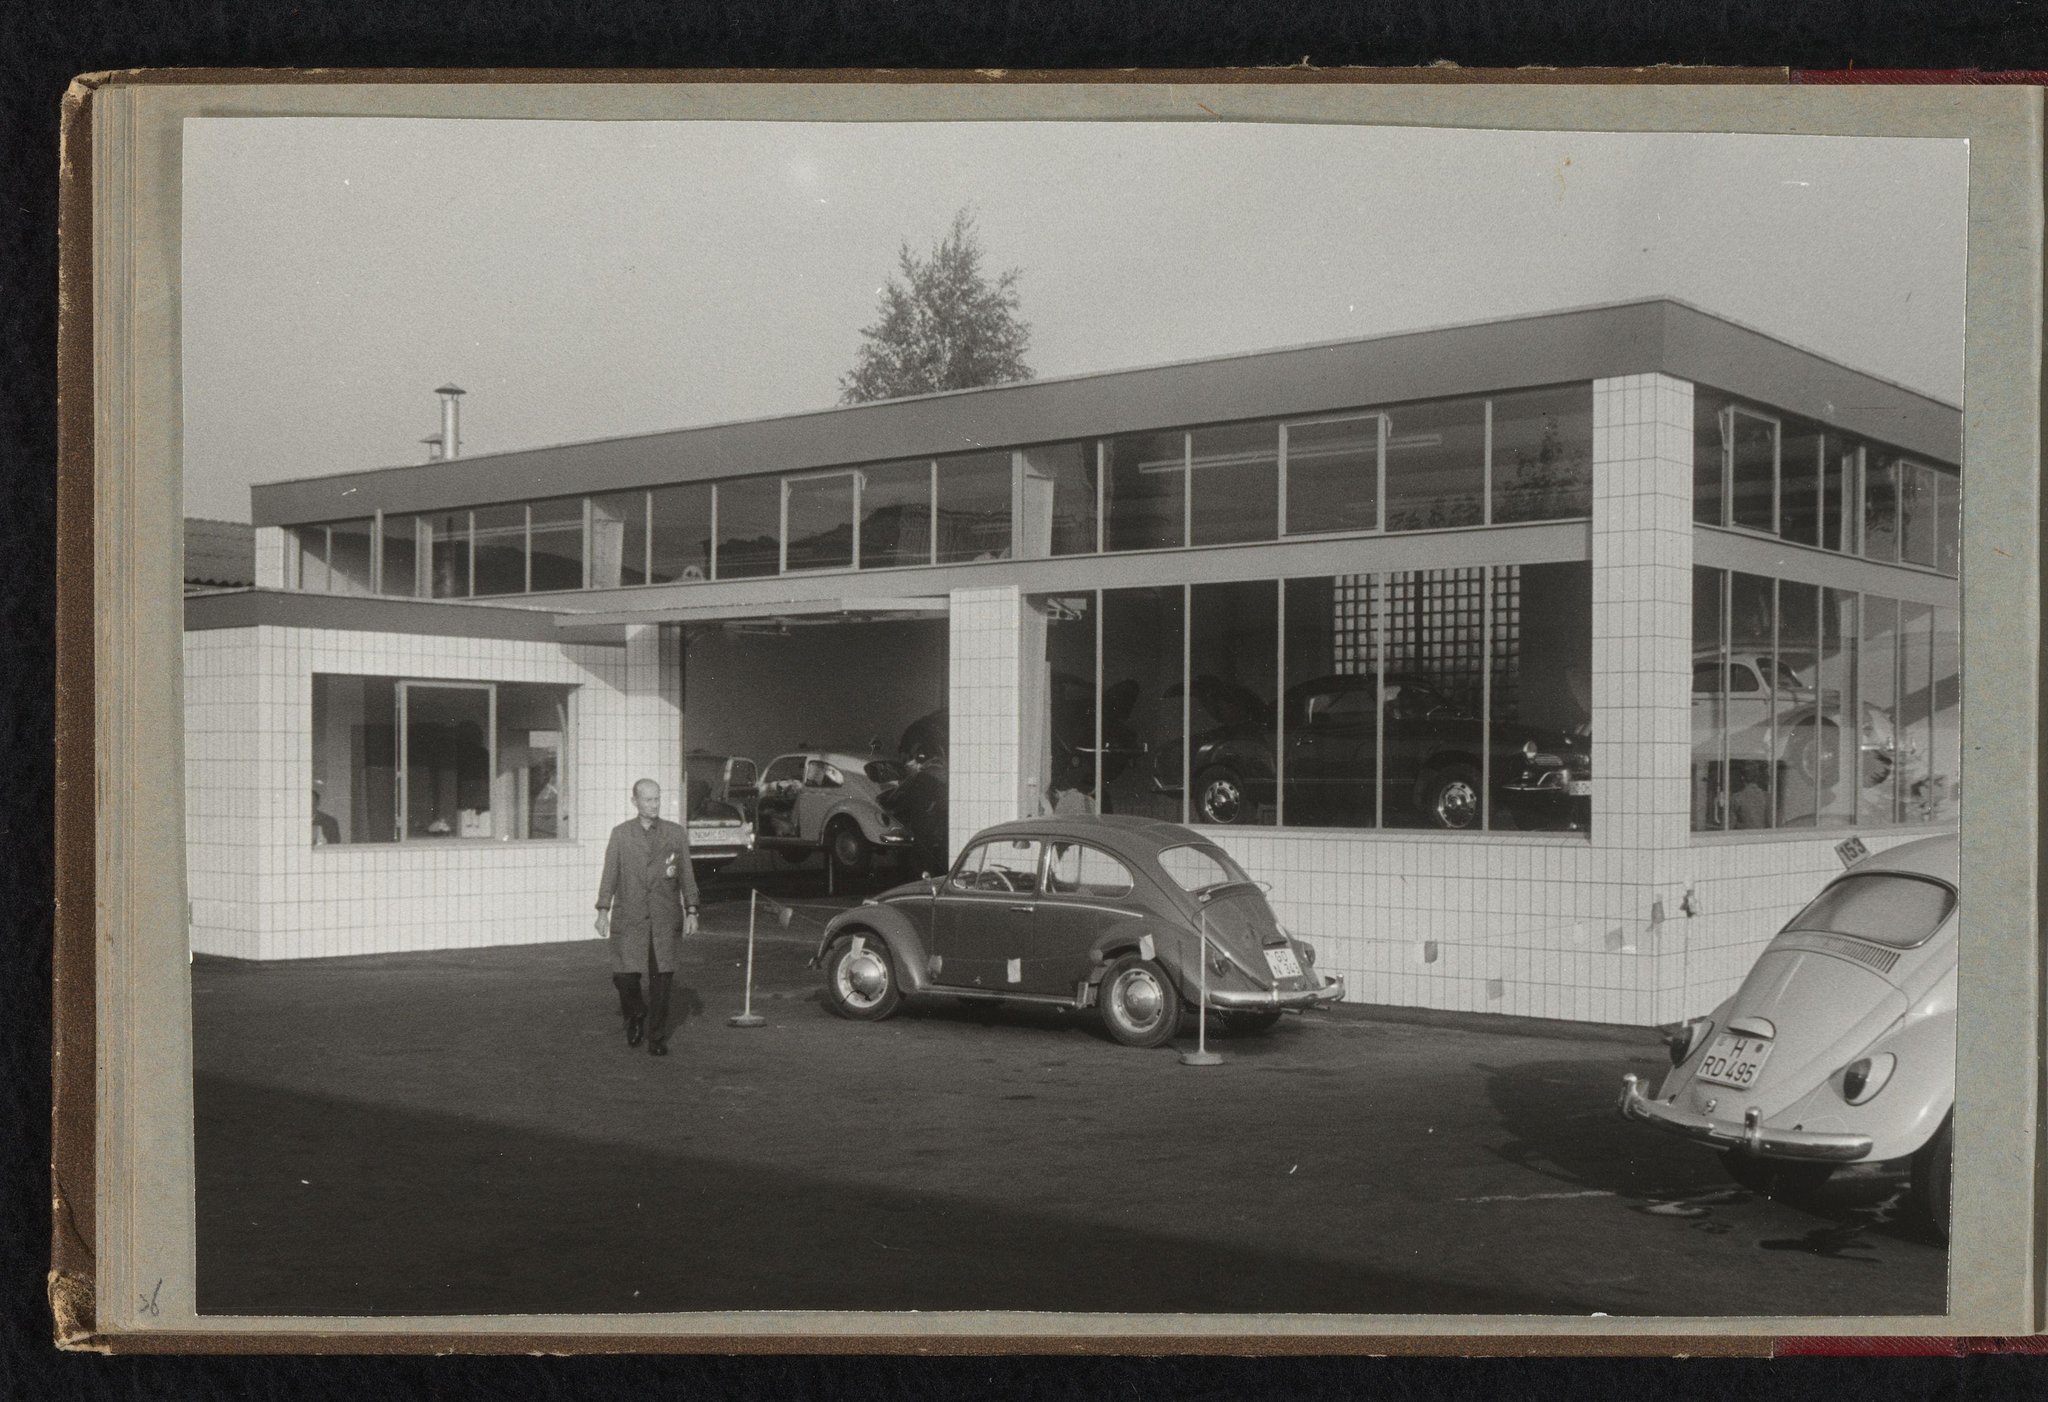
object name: photograph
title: Volkswagen garage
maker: Anonymous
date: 1955-1975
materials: paper, photographic support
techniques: gelatin silver print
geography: germany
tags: repair shop, garage for repairs, supplies etc., automobile, germany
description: Albumblad met een foto van Glitsch voor een Volkswagen garage. Onderdeel van een fotoalbum over de diensttijd van Dieter Glitsch uit Hardegsen tijdens de Tweede Wereldoorlog en de jaren daarna.